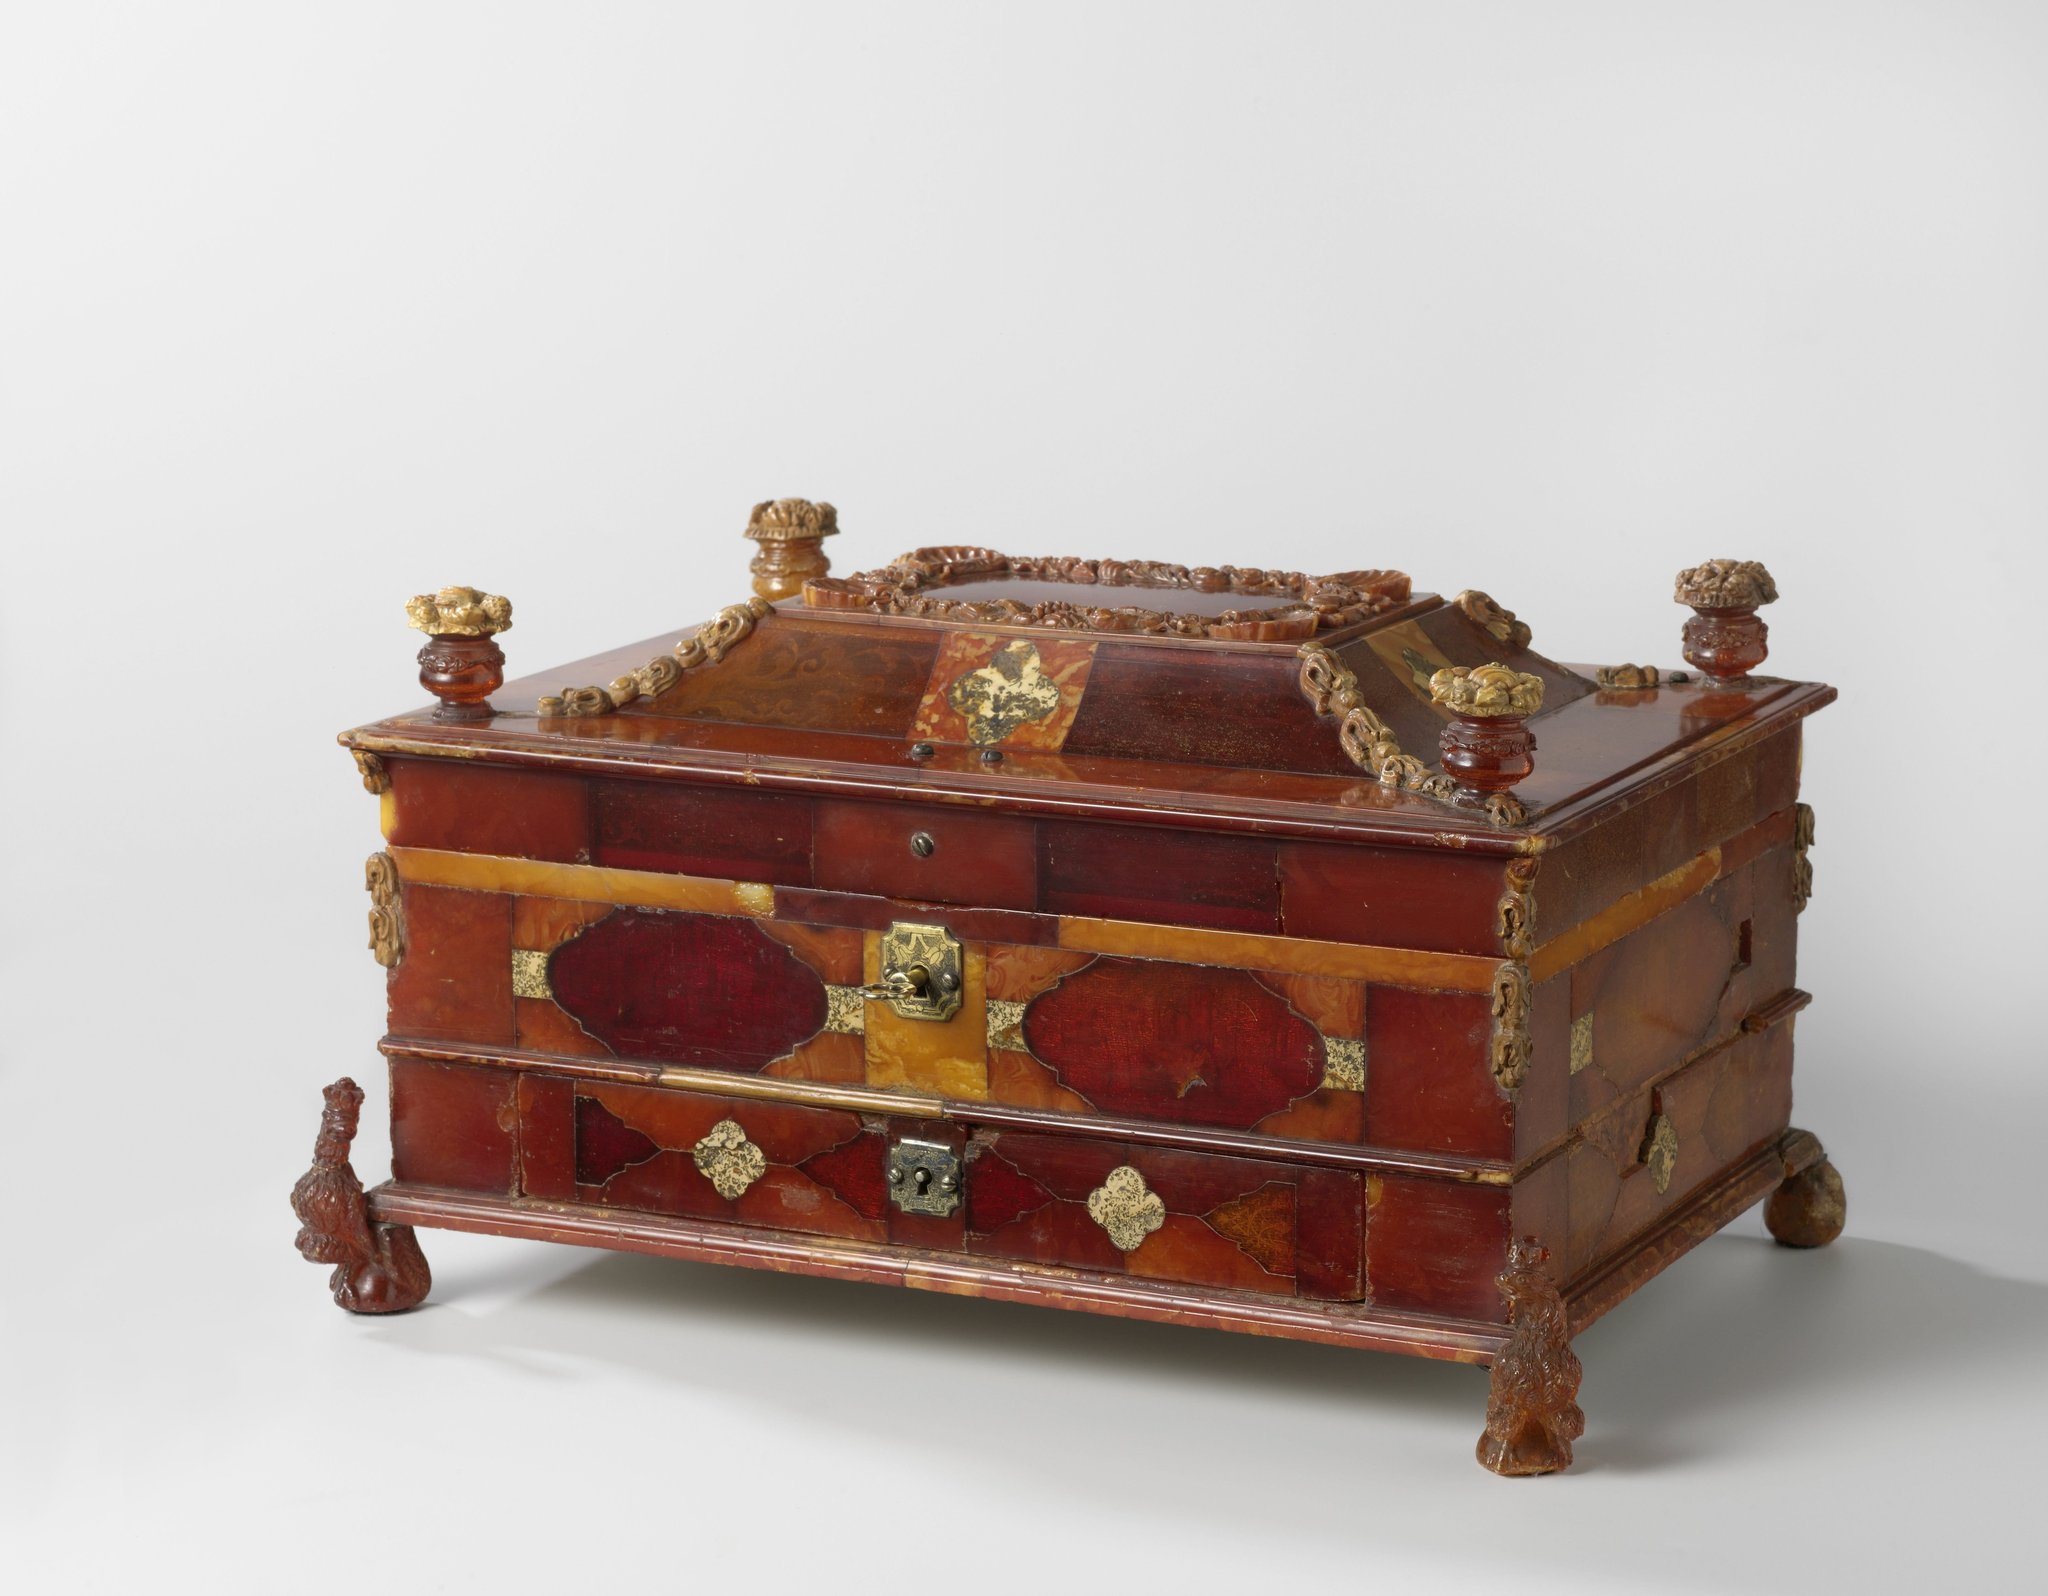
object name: musical box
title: Game Box with Four Smaller Boxes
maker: Anonymous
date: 1734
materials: amber, copper, iron, wood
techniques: gilding, intaglio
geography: danzig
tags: willem iv (prins van oranje-nassau), anna van hannover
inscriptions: coat of arms, inscription: ‘JE MAINTIENDRAI’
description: This amber box was presumably a wedding gift to Anna of Hanover and Stadtholder William IV. Amber is fossilized resin primarily found around the Baltic Sea. The princess was particularly fond of this material and even crafted items from it herself. This box was probably used to store game pieces.